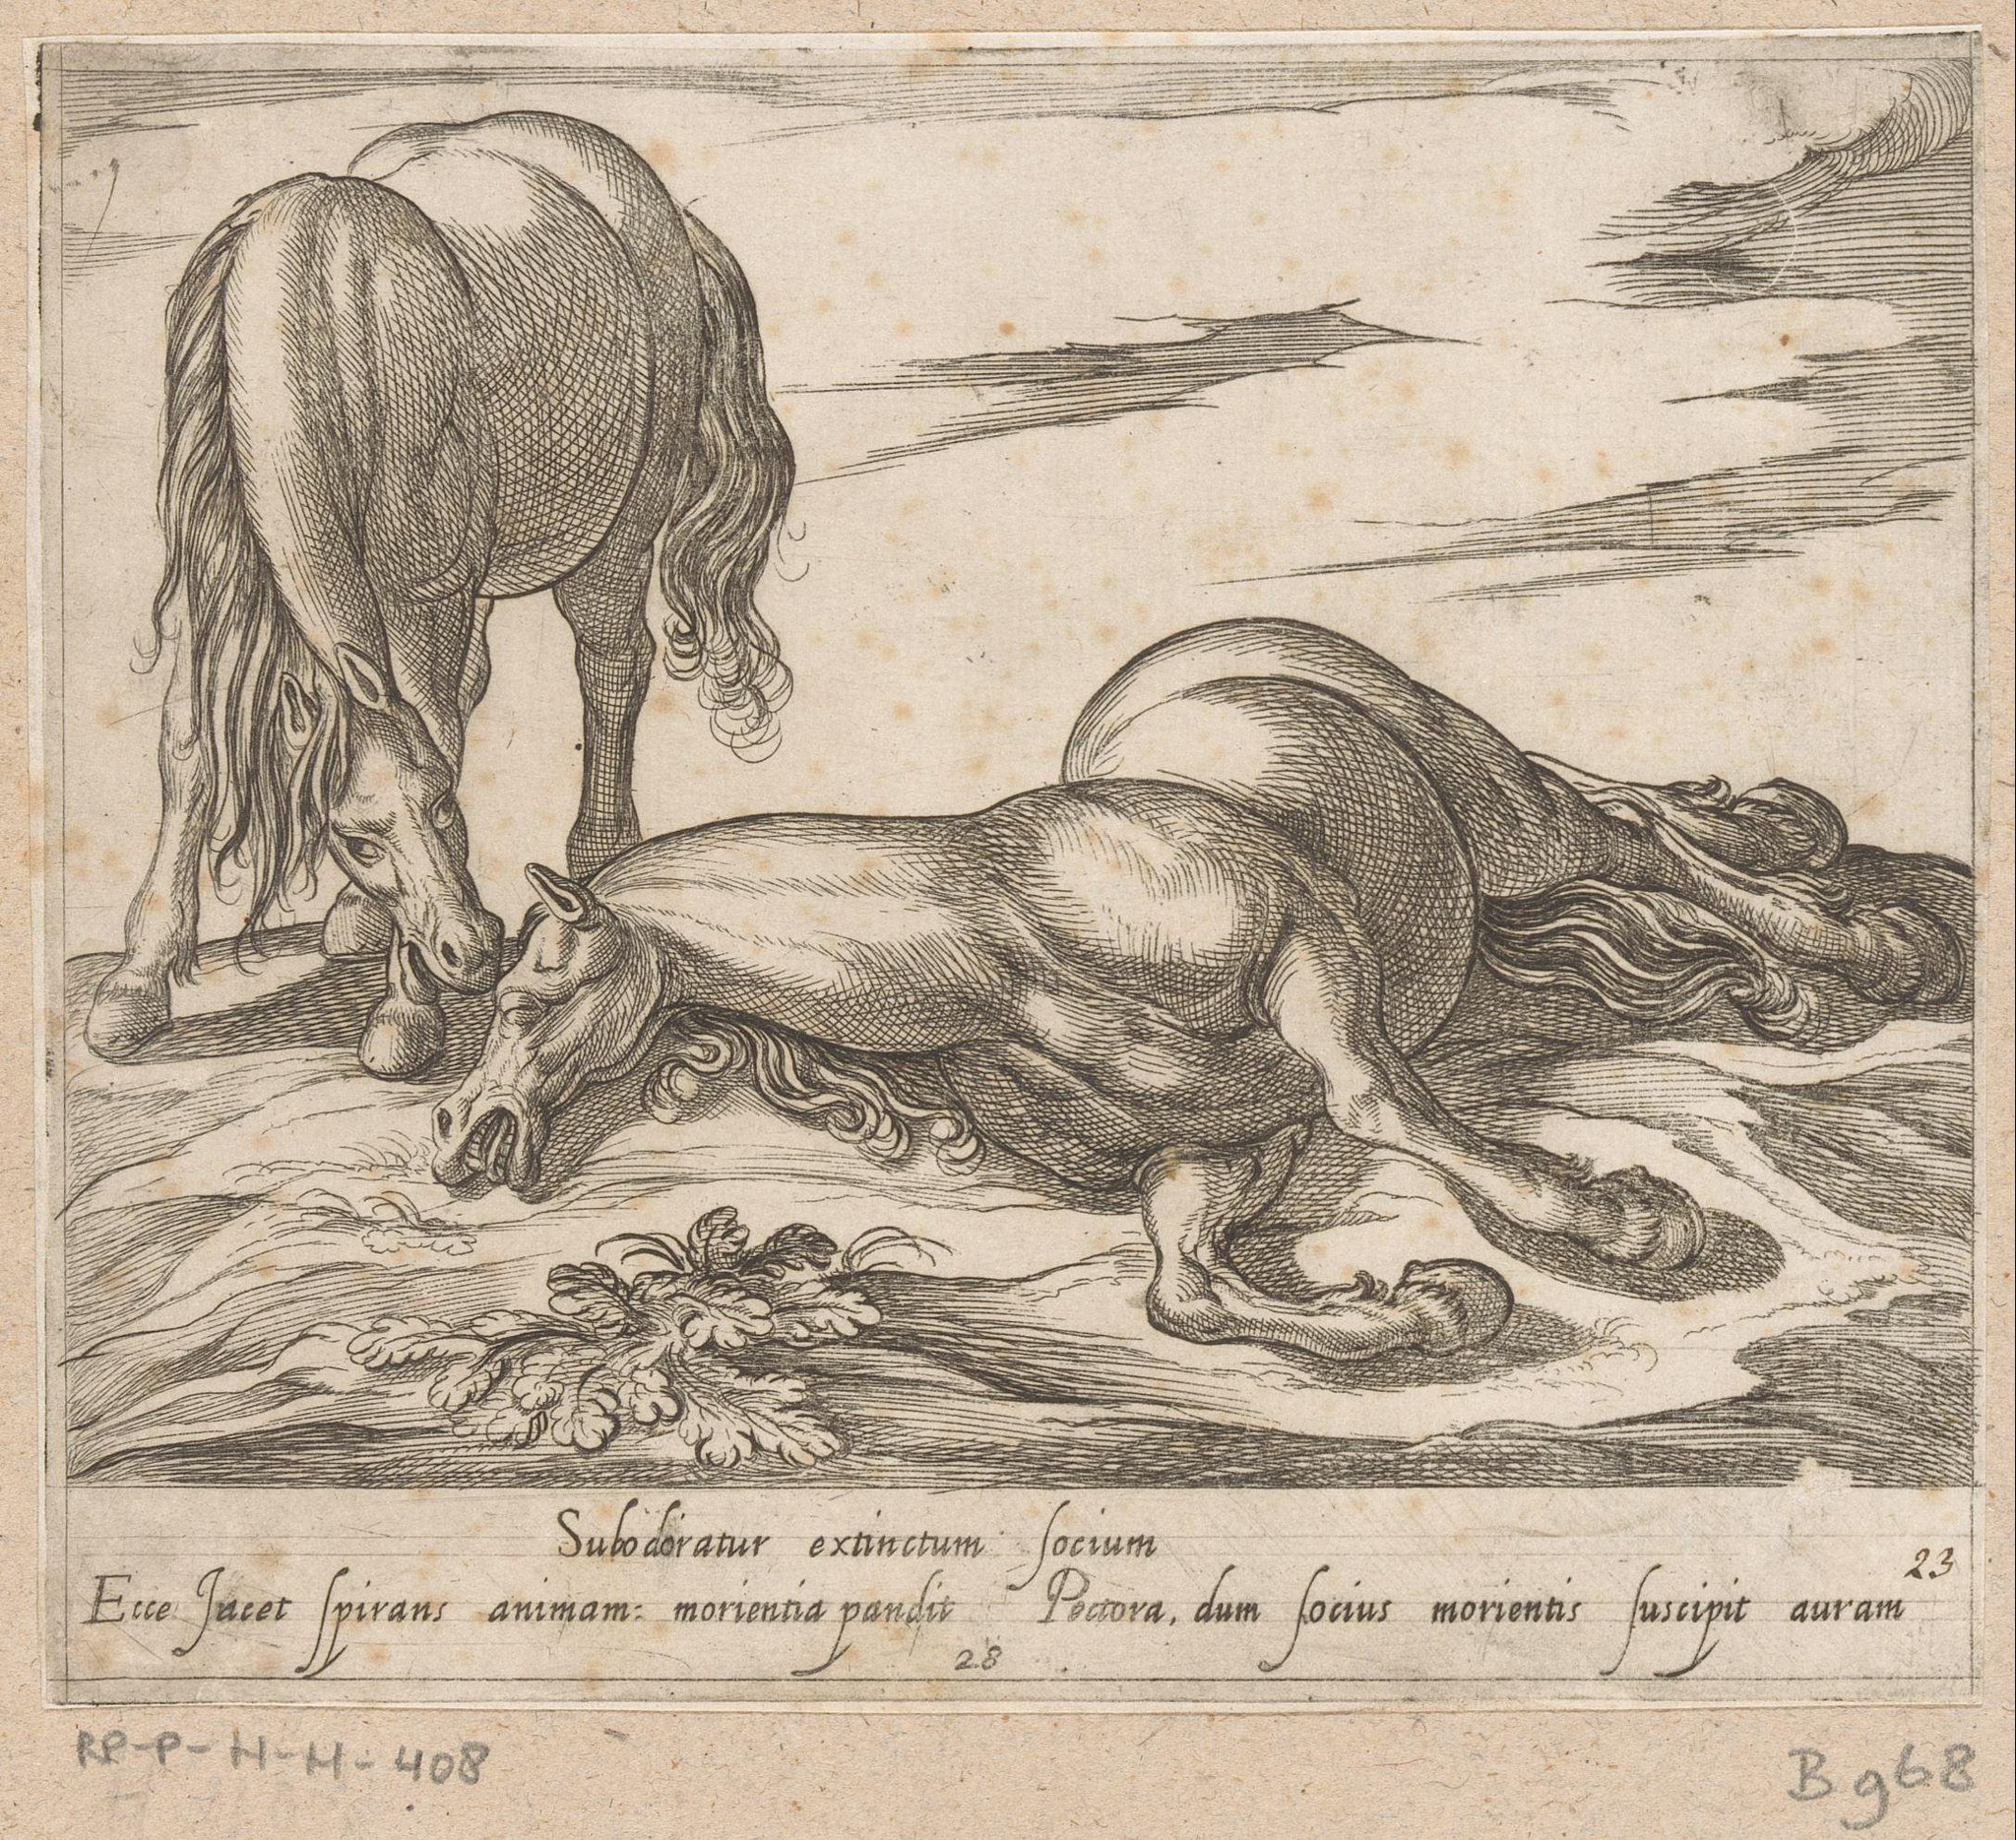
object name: print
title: Paarden uit verschillende landen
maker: antonio tempesta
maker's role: draughtsman, painter, print maker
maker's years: 1555-1630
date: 1590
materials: paper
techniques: etching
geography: italy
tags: horse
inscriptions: collector's mark: Lugt 11, collector's mark: ‘Hinloopen’, number: ‘23’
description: Deze prent maakt deel uit van een reeks van 28 prenten van paarden (+ titelprent en opdracht).